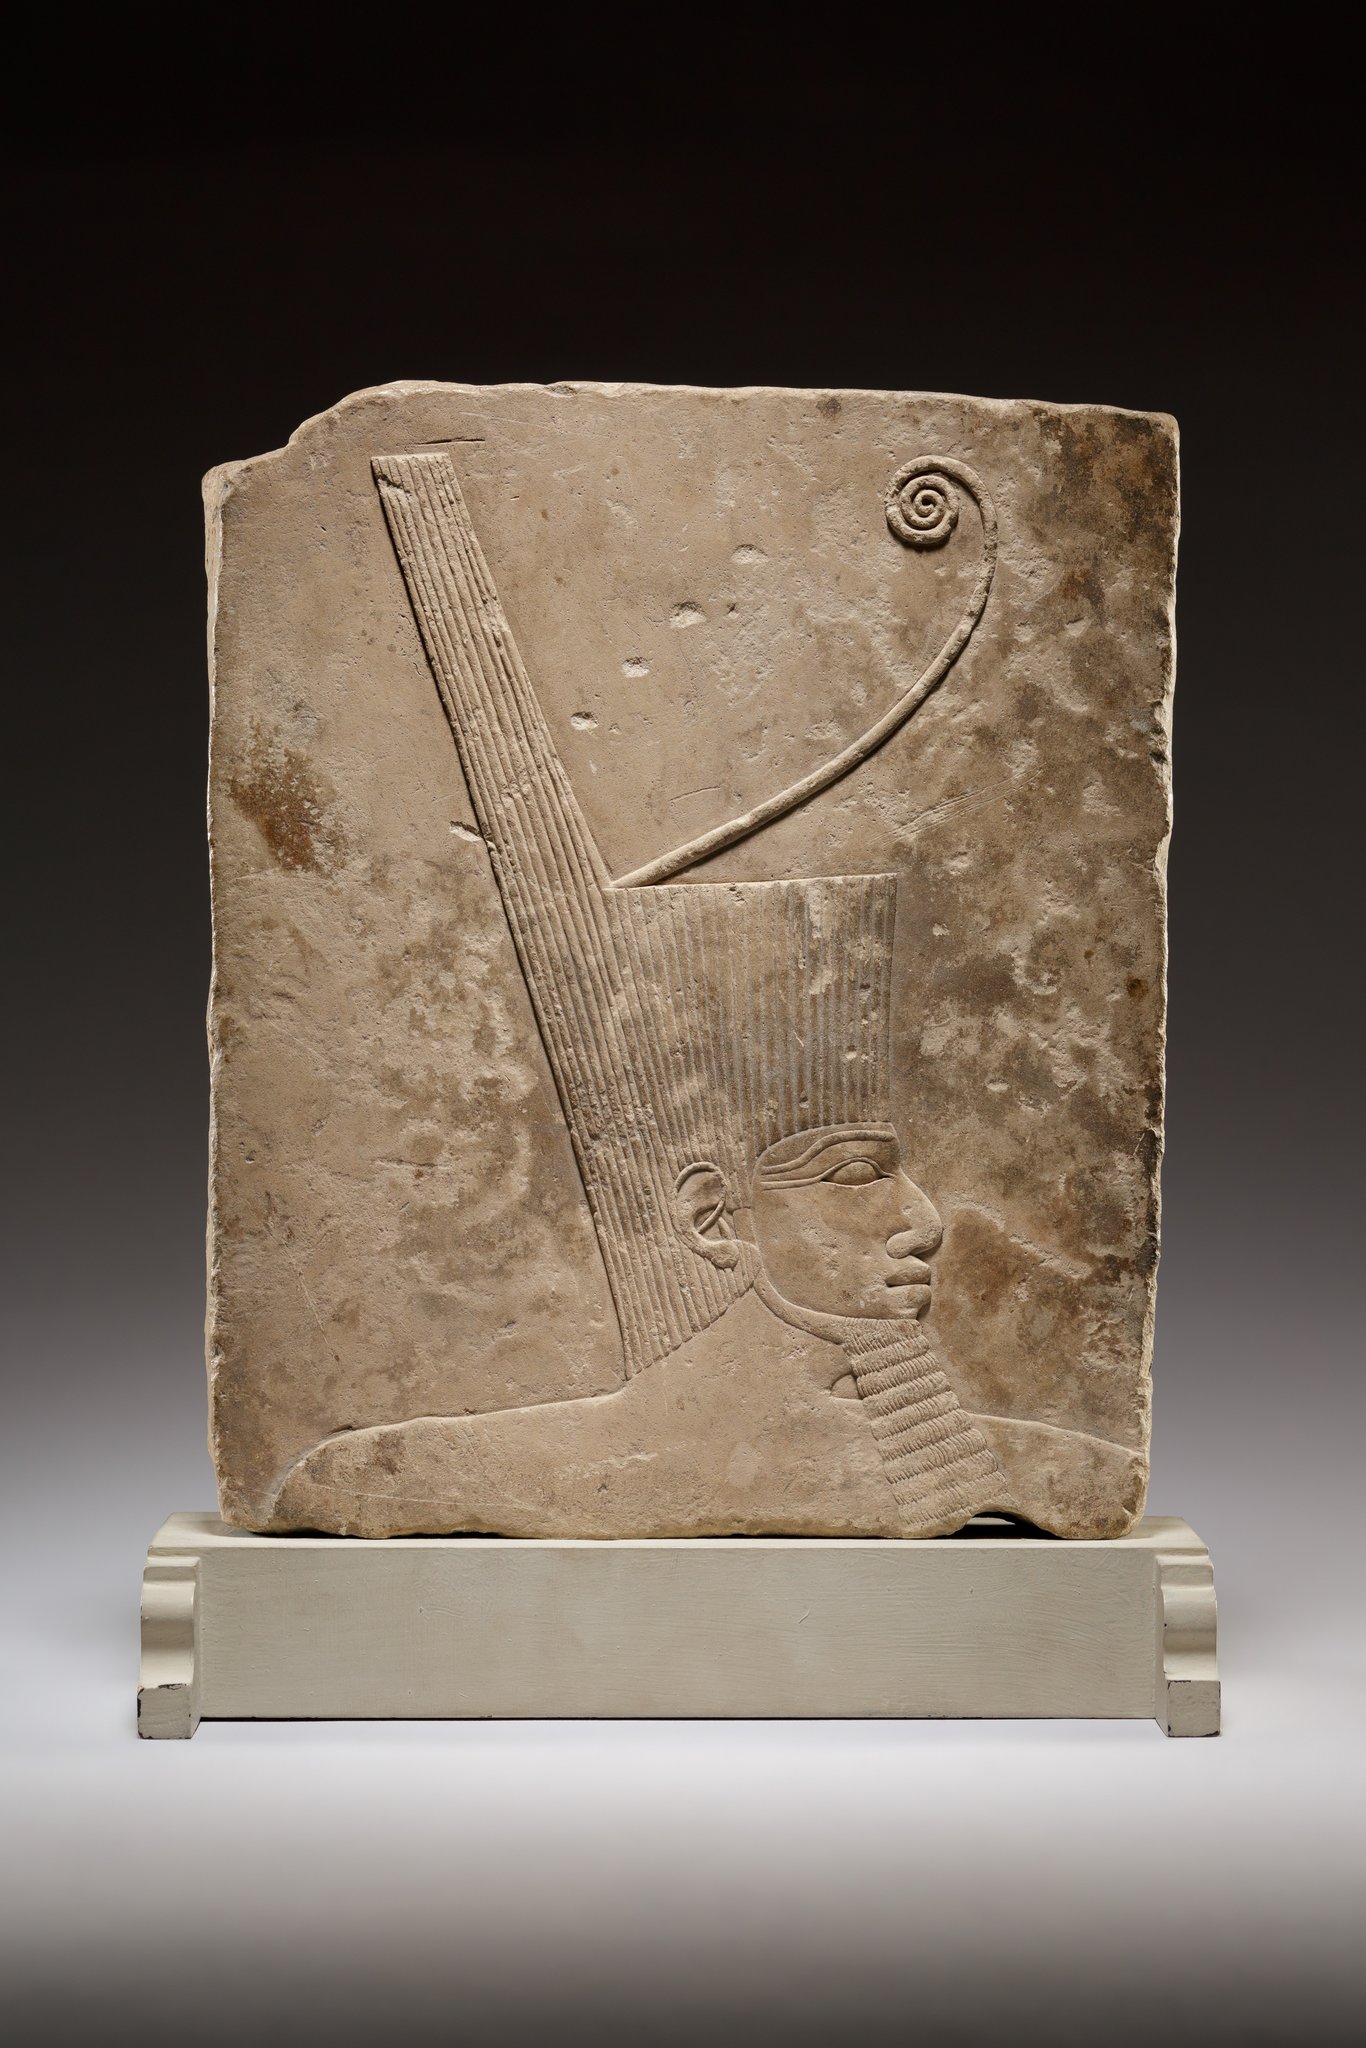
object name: sculptor's model votive, king in red crown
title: Plaque Showing a King in the Red Crown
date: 767-735 BCE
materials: limestone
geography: the delta